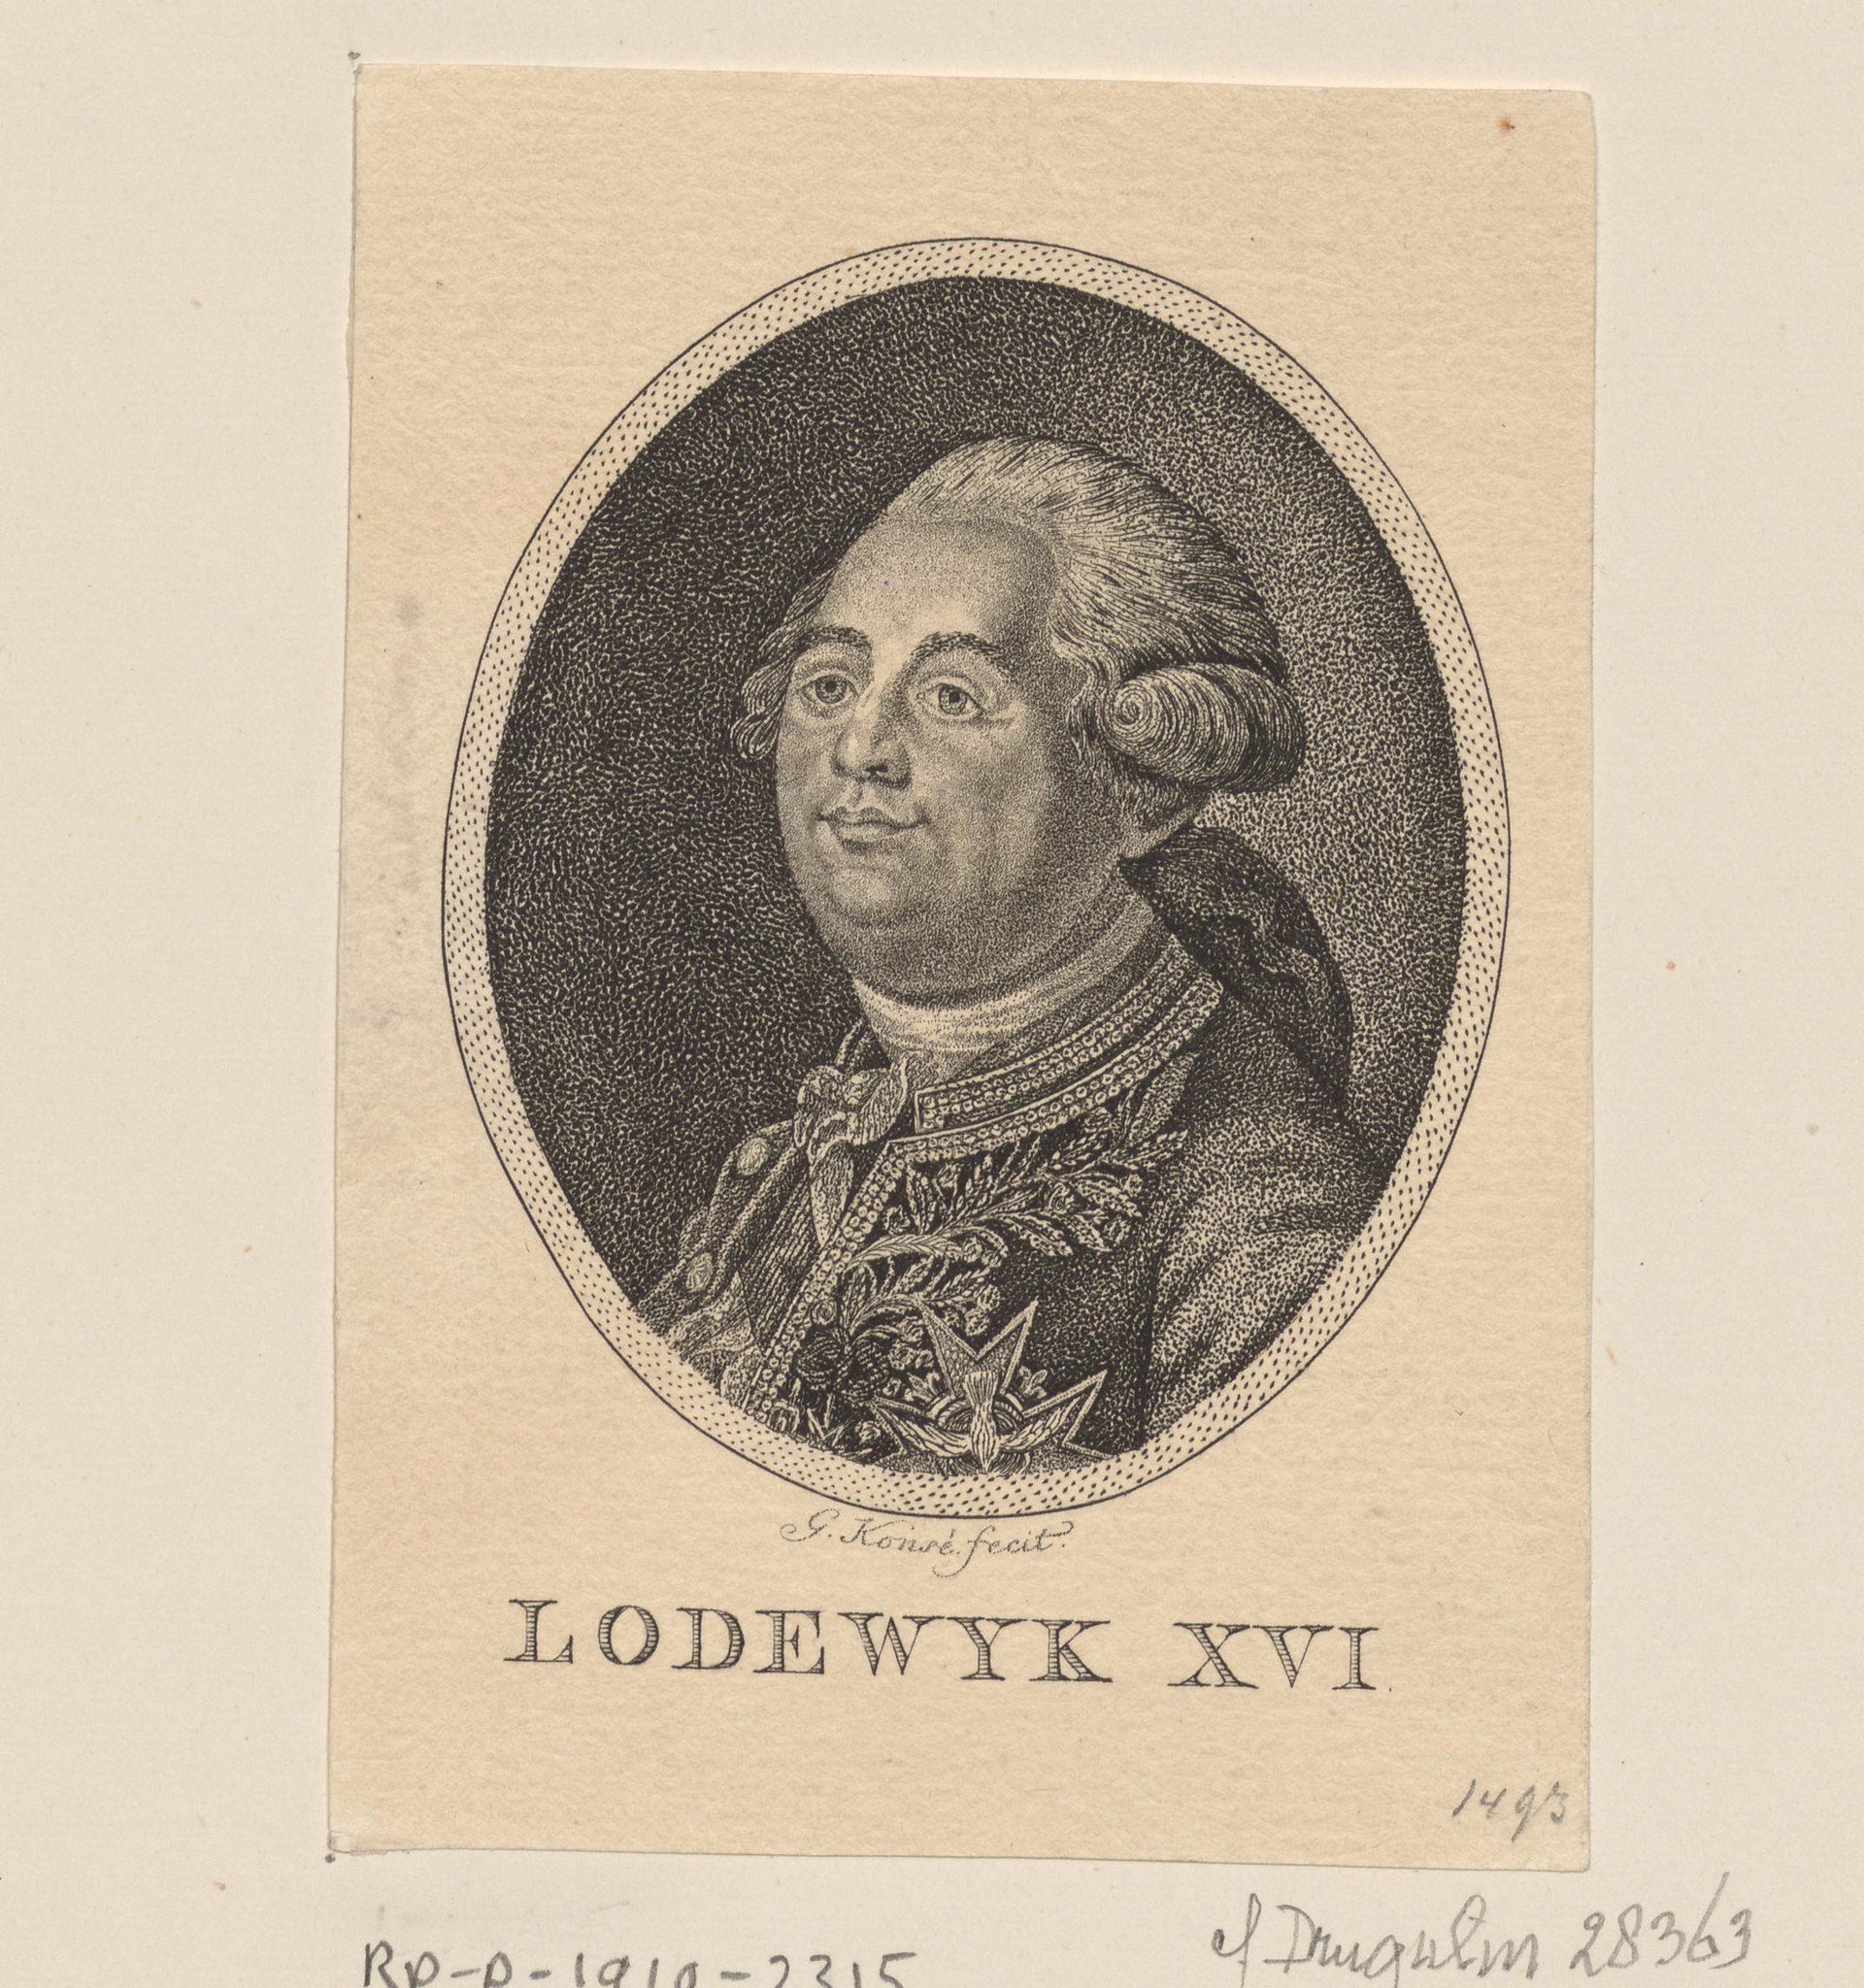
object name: print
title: Portret van Lodewijk XVI van Frankrijk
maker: gerrit konsé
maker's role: print maker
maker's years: 1751-1826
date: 1784-1826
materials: paper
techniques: etching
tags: paris, lodewijk xvi (koning van frankrijk), historical persons, wig, king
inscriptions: collector's mark: Lugt 2228